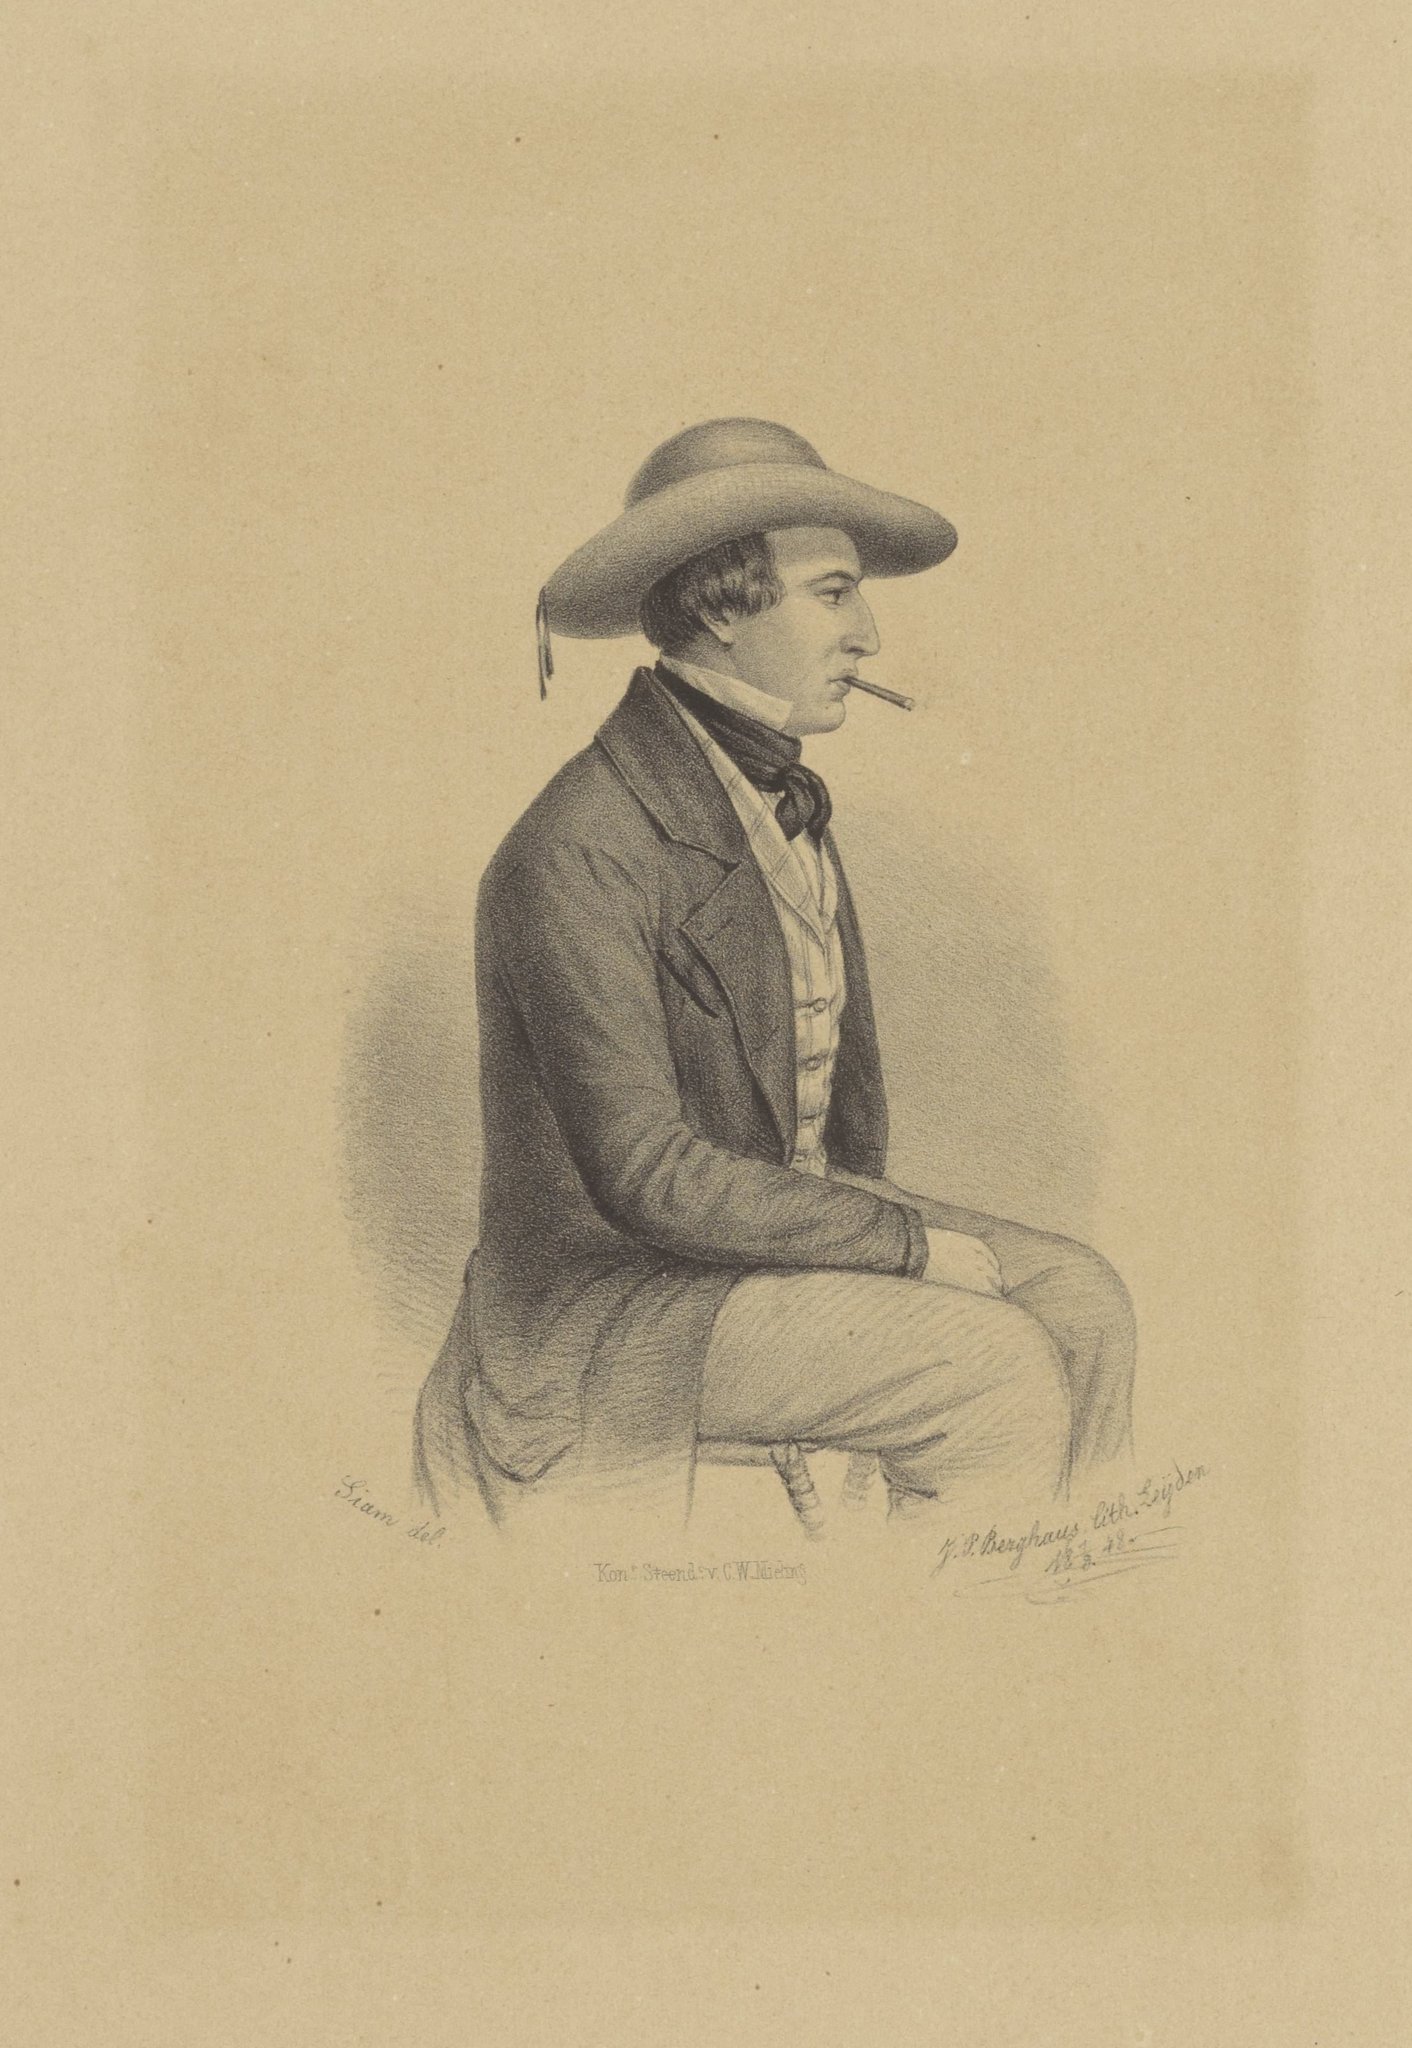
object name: print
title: Portret van Jean Henri de Laat de Kanter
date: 1848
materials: paper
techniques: lithograph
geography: leiden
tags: amsterdam, historical persons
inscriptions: collector's mark: Lugt 2228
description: De geportretteerde zit op een kruk. Hij is en profil afgebeeld, draagt een hoed en heeft een sigaar in zijn mond.